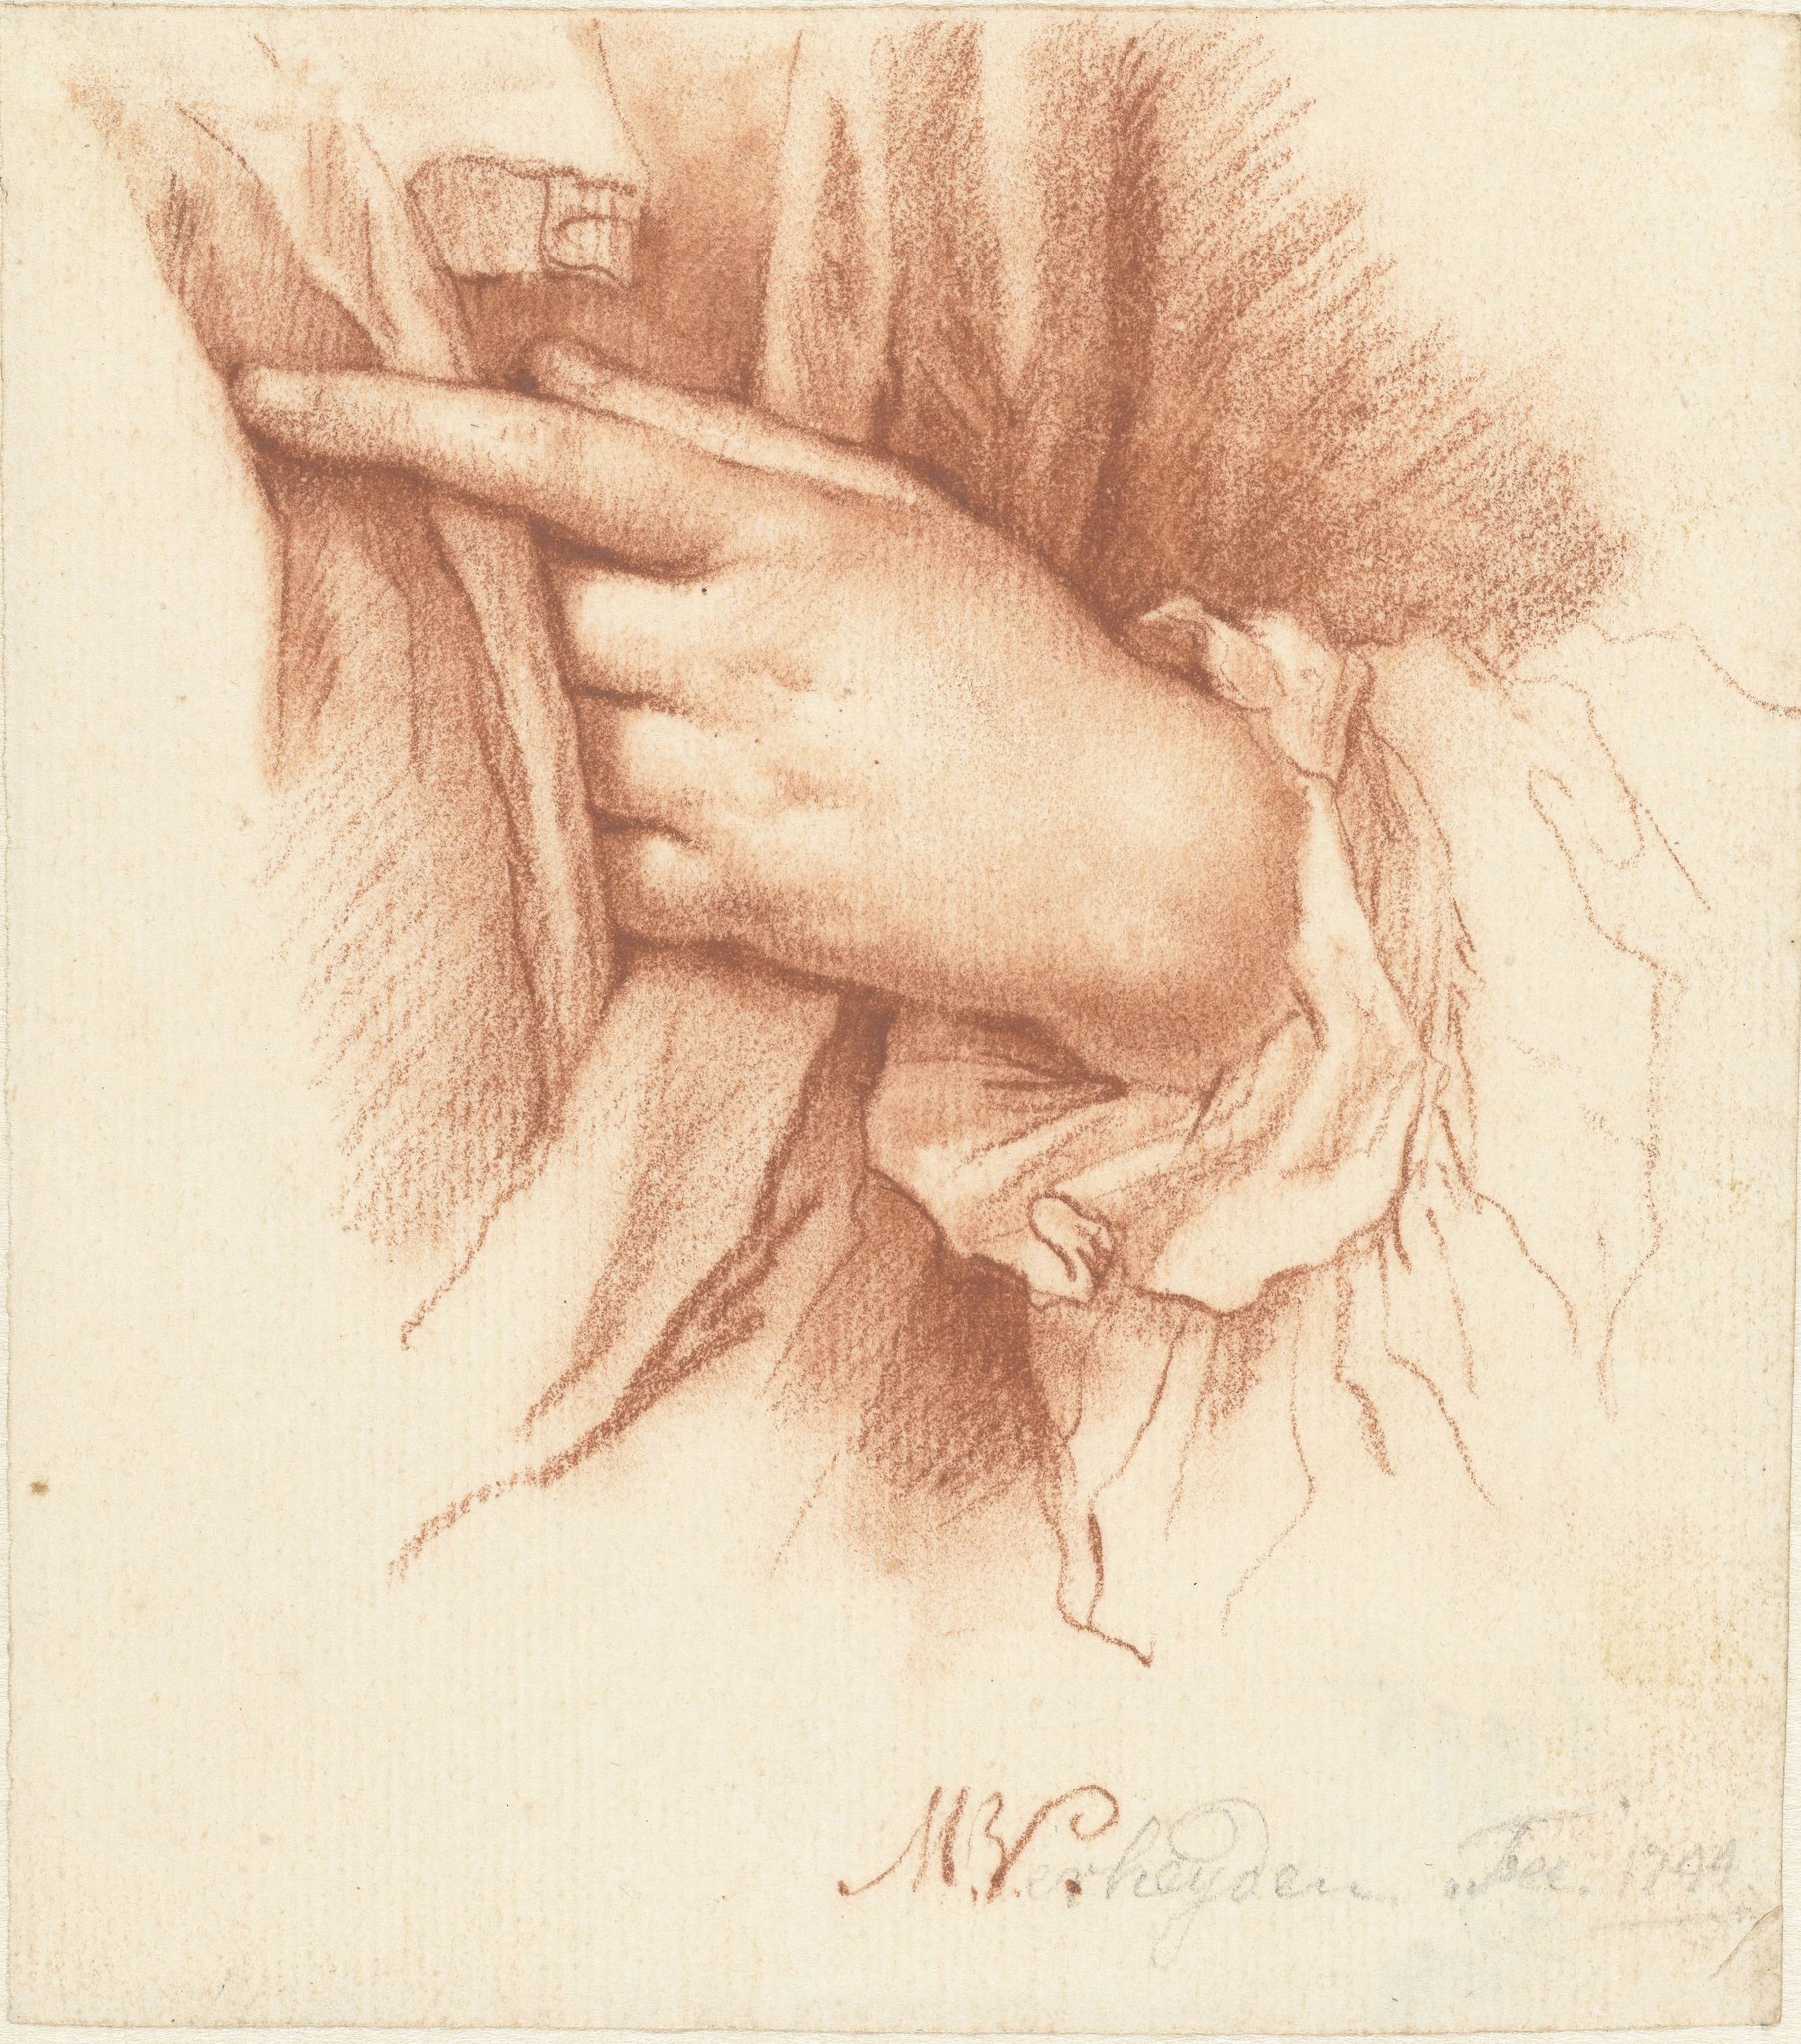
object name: drawing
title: Studie van een linkerhand in draperie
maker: mattheus verheyden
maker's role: draughtsman, painter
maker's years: 1700-1777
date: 1744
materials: chalk, paper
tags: hand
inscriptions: signature: ‘M.V.erheijden fec 1744’